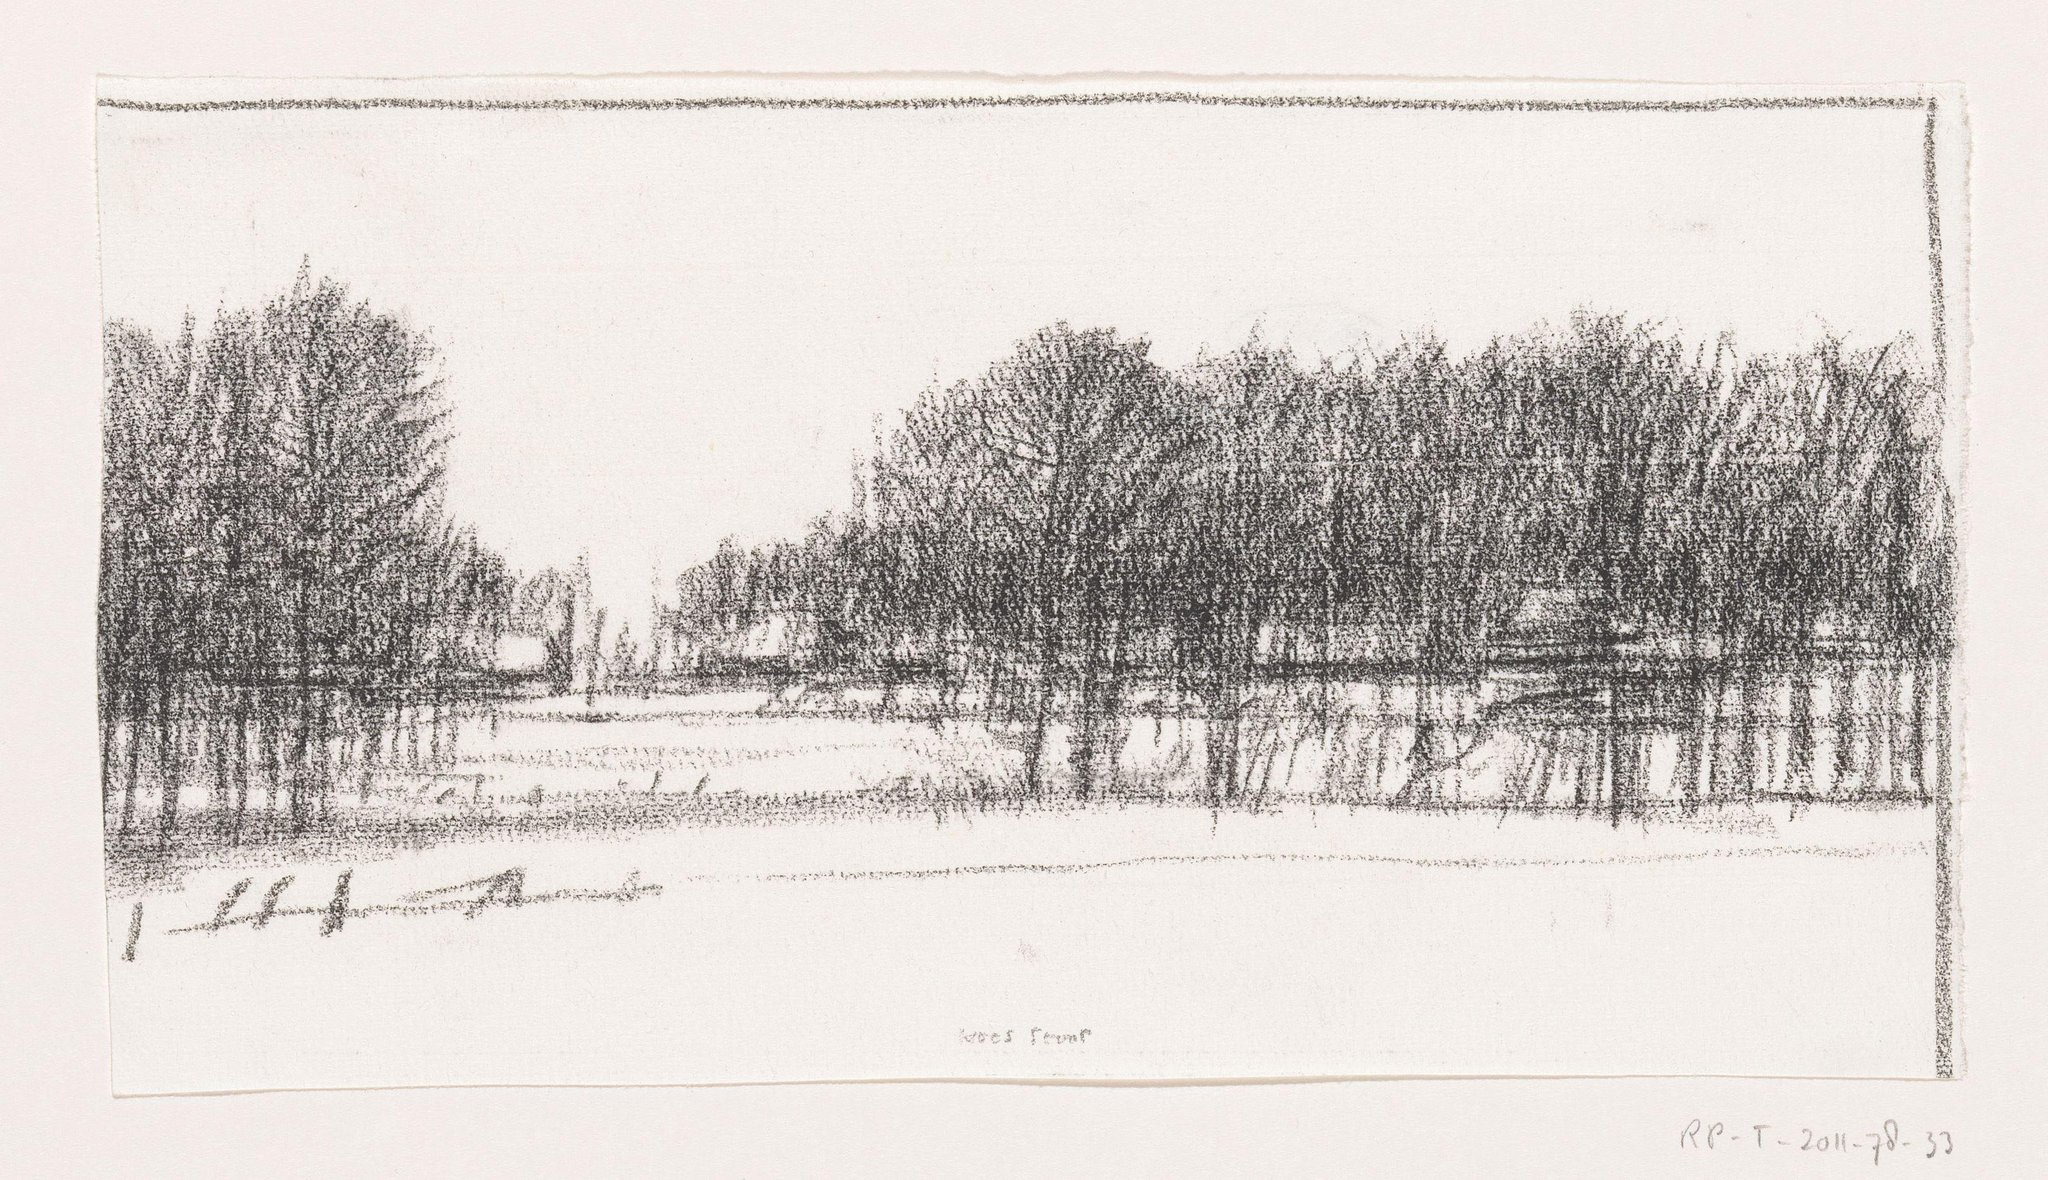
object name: drawing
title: Landschap met bomen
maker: kees stoop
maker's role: draughtsman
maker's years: 1929-2019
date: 1939-2009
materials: charcoal, paper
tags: farm or solitary house in landscape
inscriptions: signature: ‘KEES STOOP’